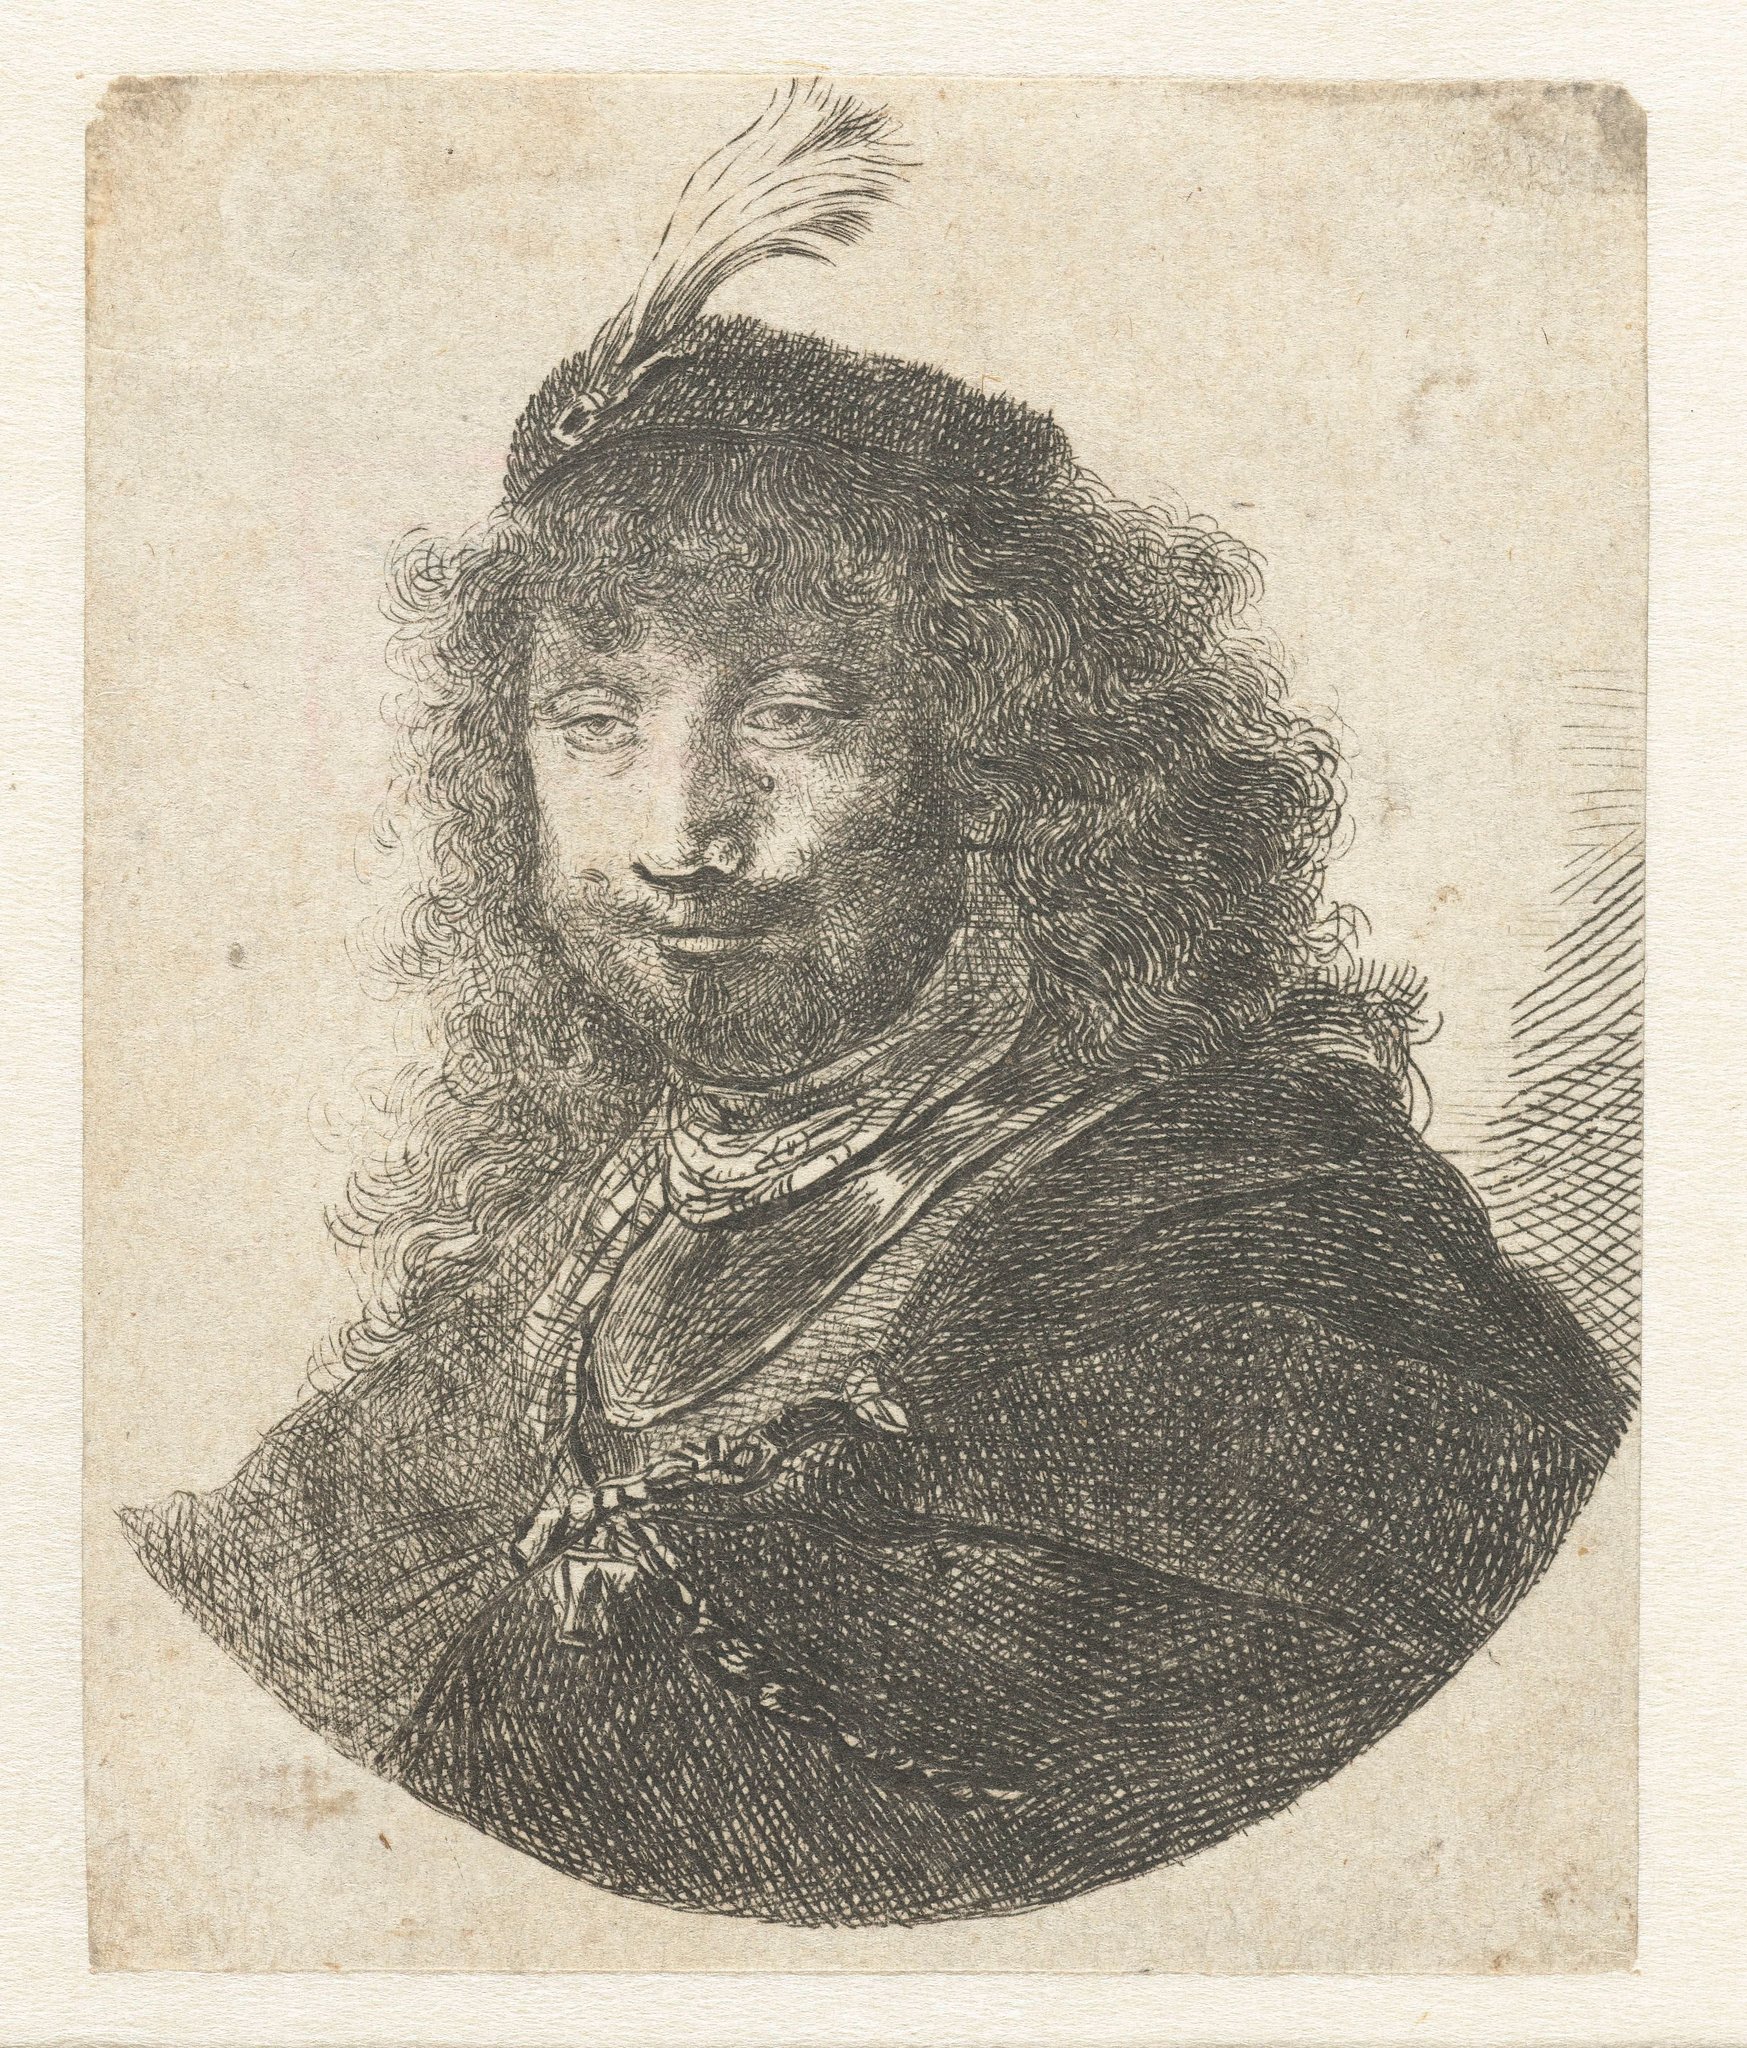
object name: print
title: Self-portrait (?) with plumed cap and lowered sabre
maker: Anonymous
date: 1634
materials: paper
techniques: etching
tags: leiden, amsterdam, painter, rembrandt van rijn, portrait, self-portrait of graphic artist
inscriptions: stamp, collector's mark: Lugt 2760, collector's mark: Lugt 2228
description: Spiegelbeeldige kopie naar de gelijknamige prent van Rembrandt.